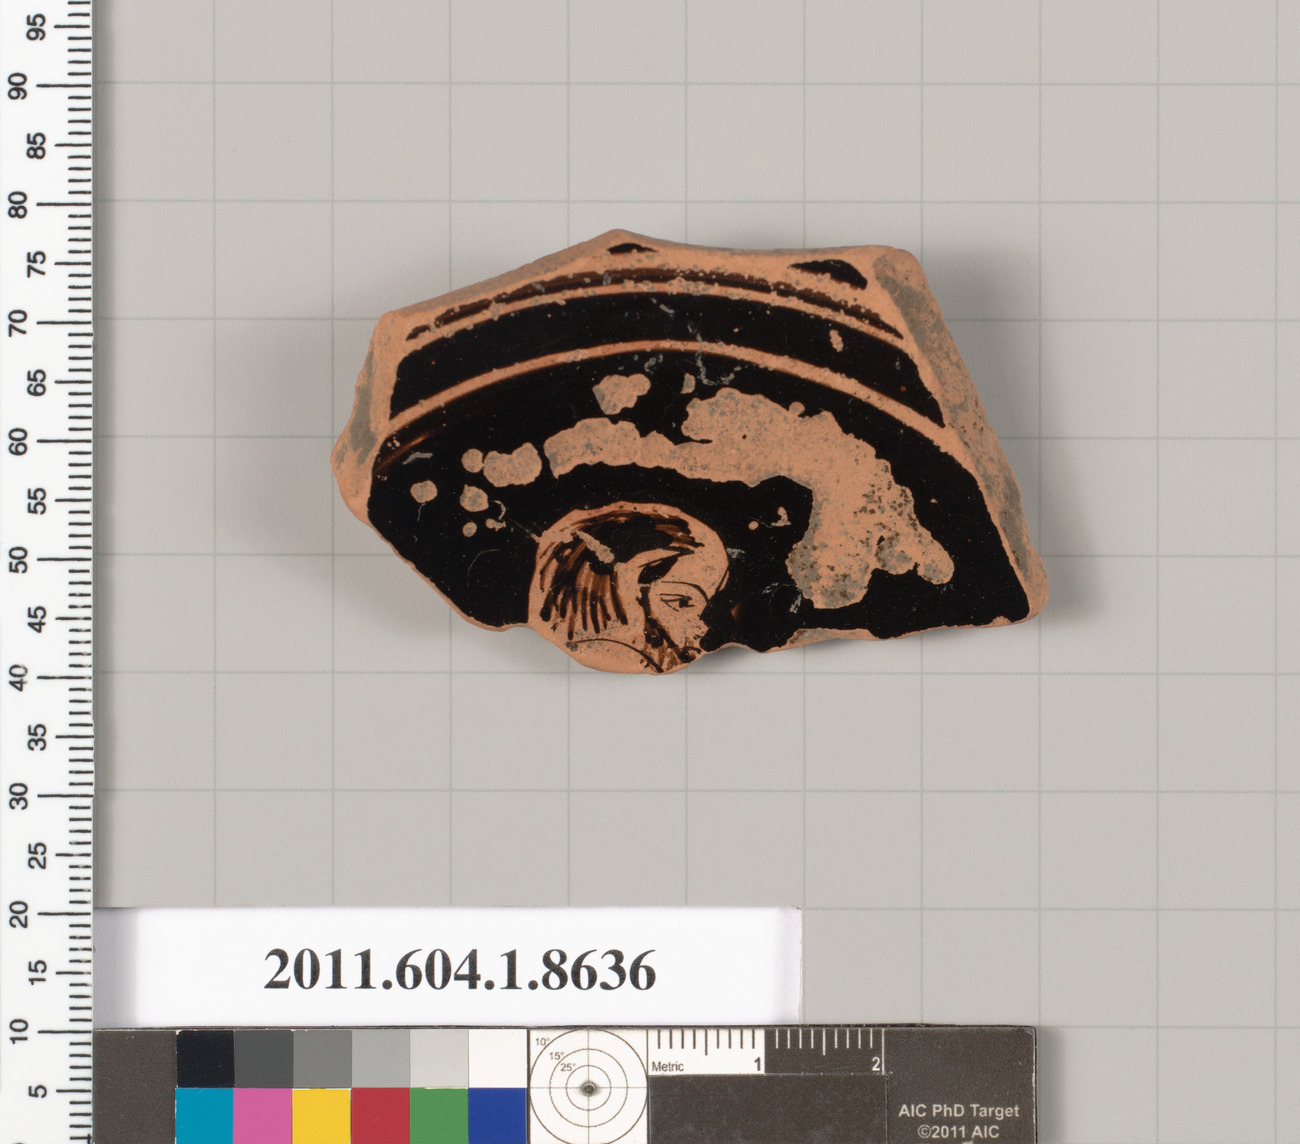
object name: kylix fragment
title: Terracotta fragment of a stemless kylix (drinking cup)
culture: greek, attic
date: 467-435 BCE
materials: terracotta